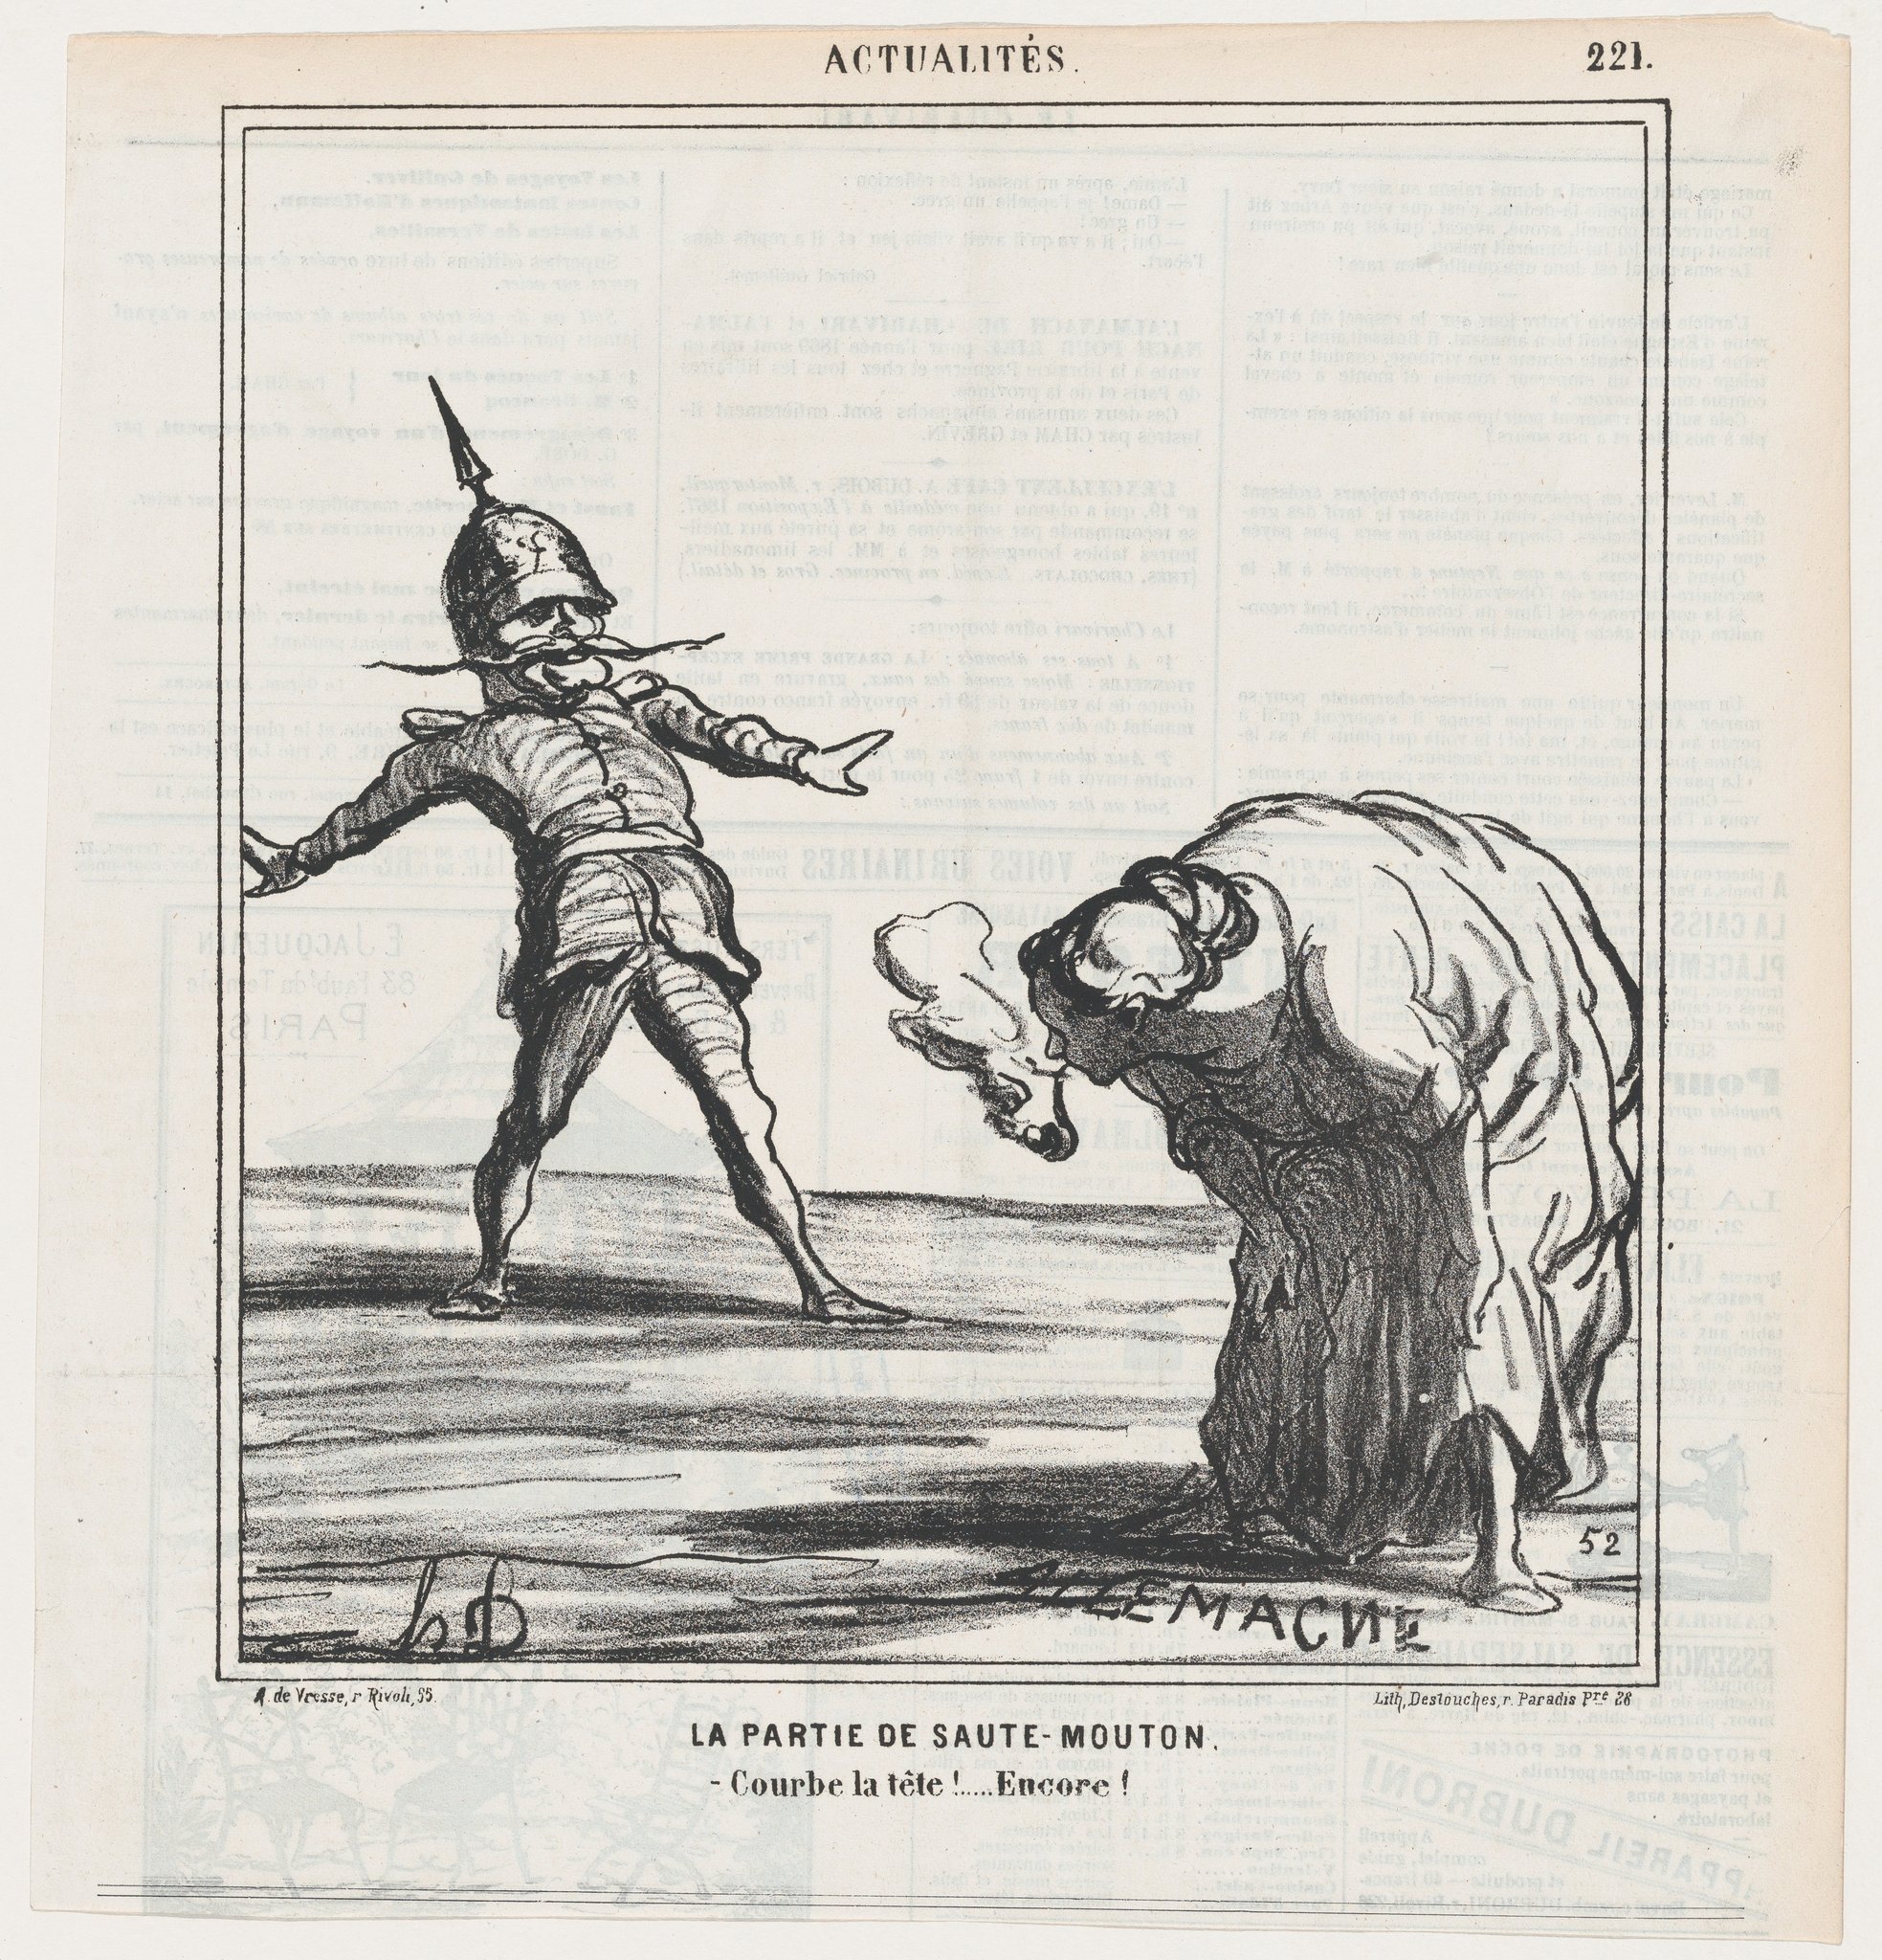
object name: print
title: The leapfrog game: Bend your head down! Again!, from 'News of the day,' published in "Le Charivari"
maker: honoré daumier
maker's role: artist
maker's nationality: french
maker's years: 1808-1879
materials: paper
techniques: lithograph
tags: satire,men,women